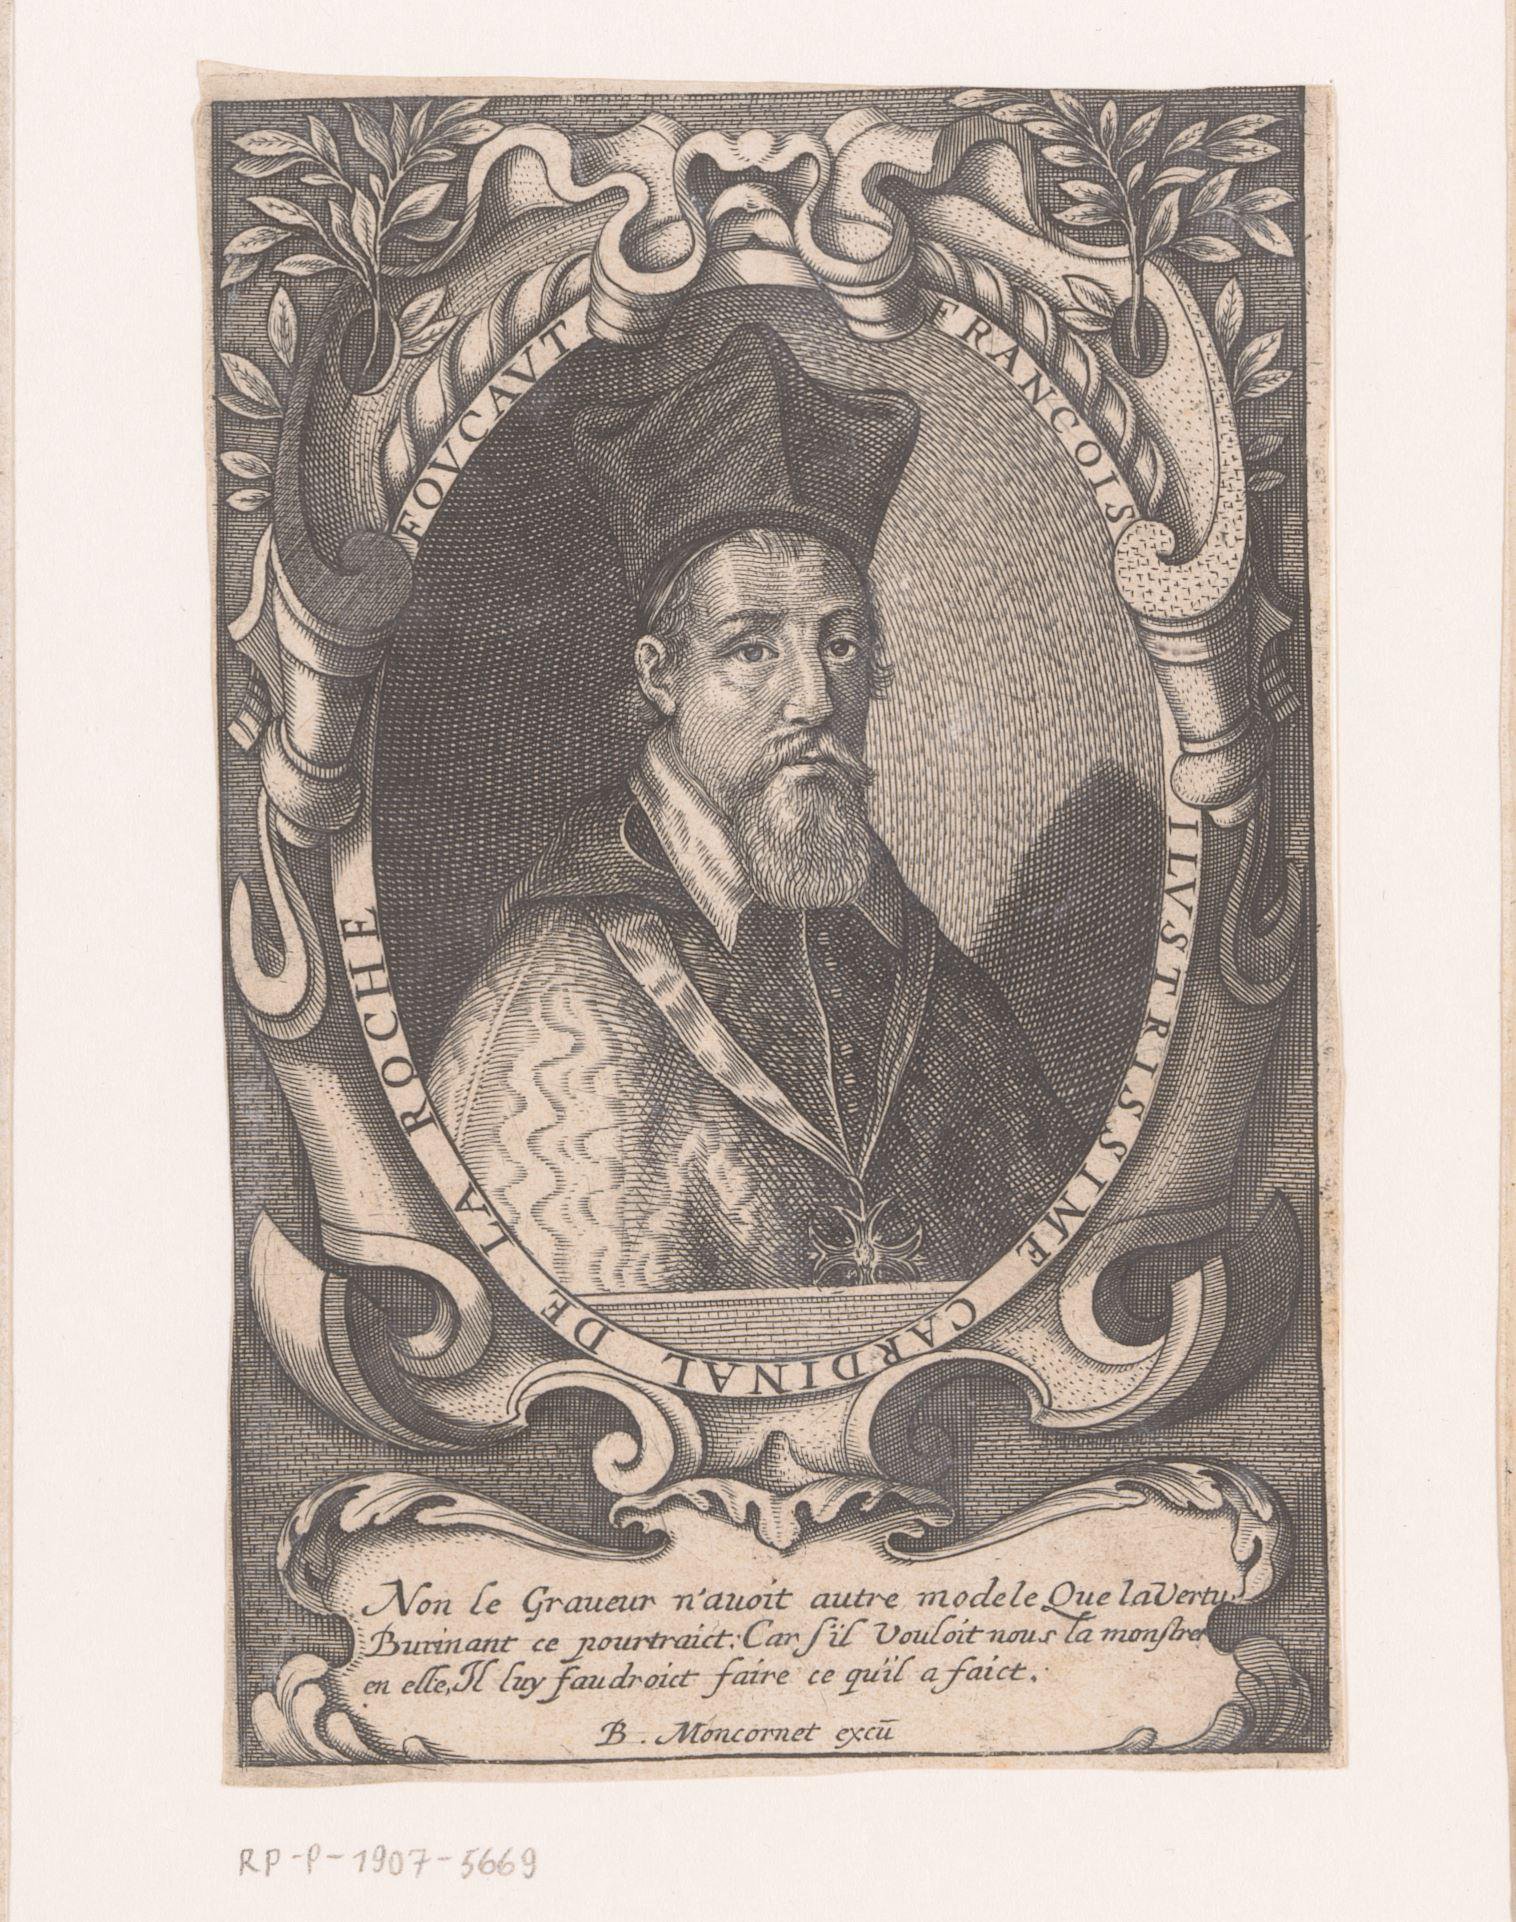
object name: print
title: Portret van François de La Rochefoucauld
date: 1610-1668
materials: paper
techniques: engraving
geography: paris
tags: paris, priest, françois de la rochefoucauld, cardinal, historical persons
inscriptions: collector's mark: Lugt 2228